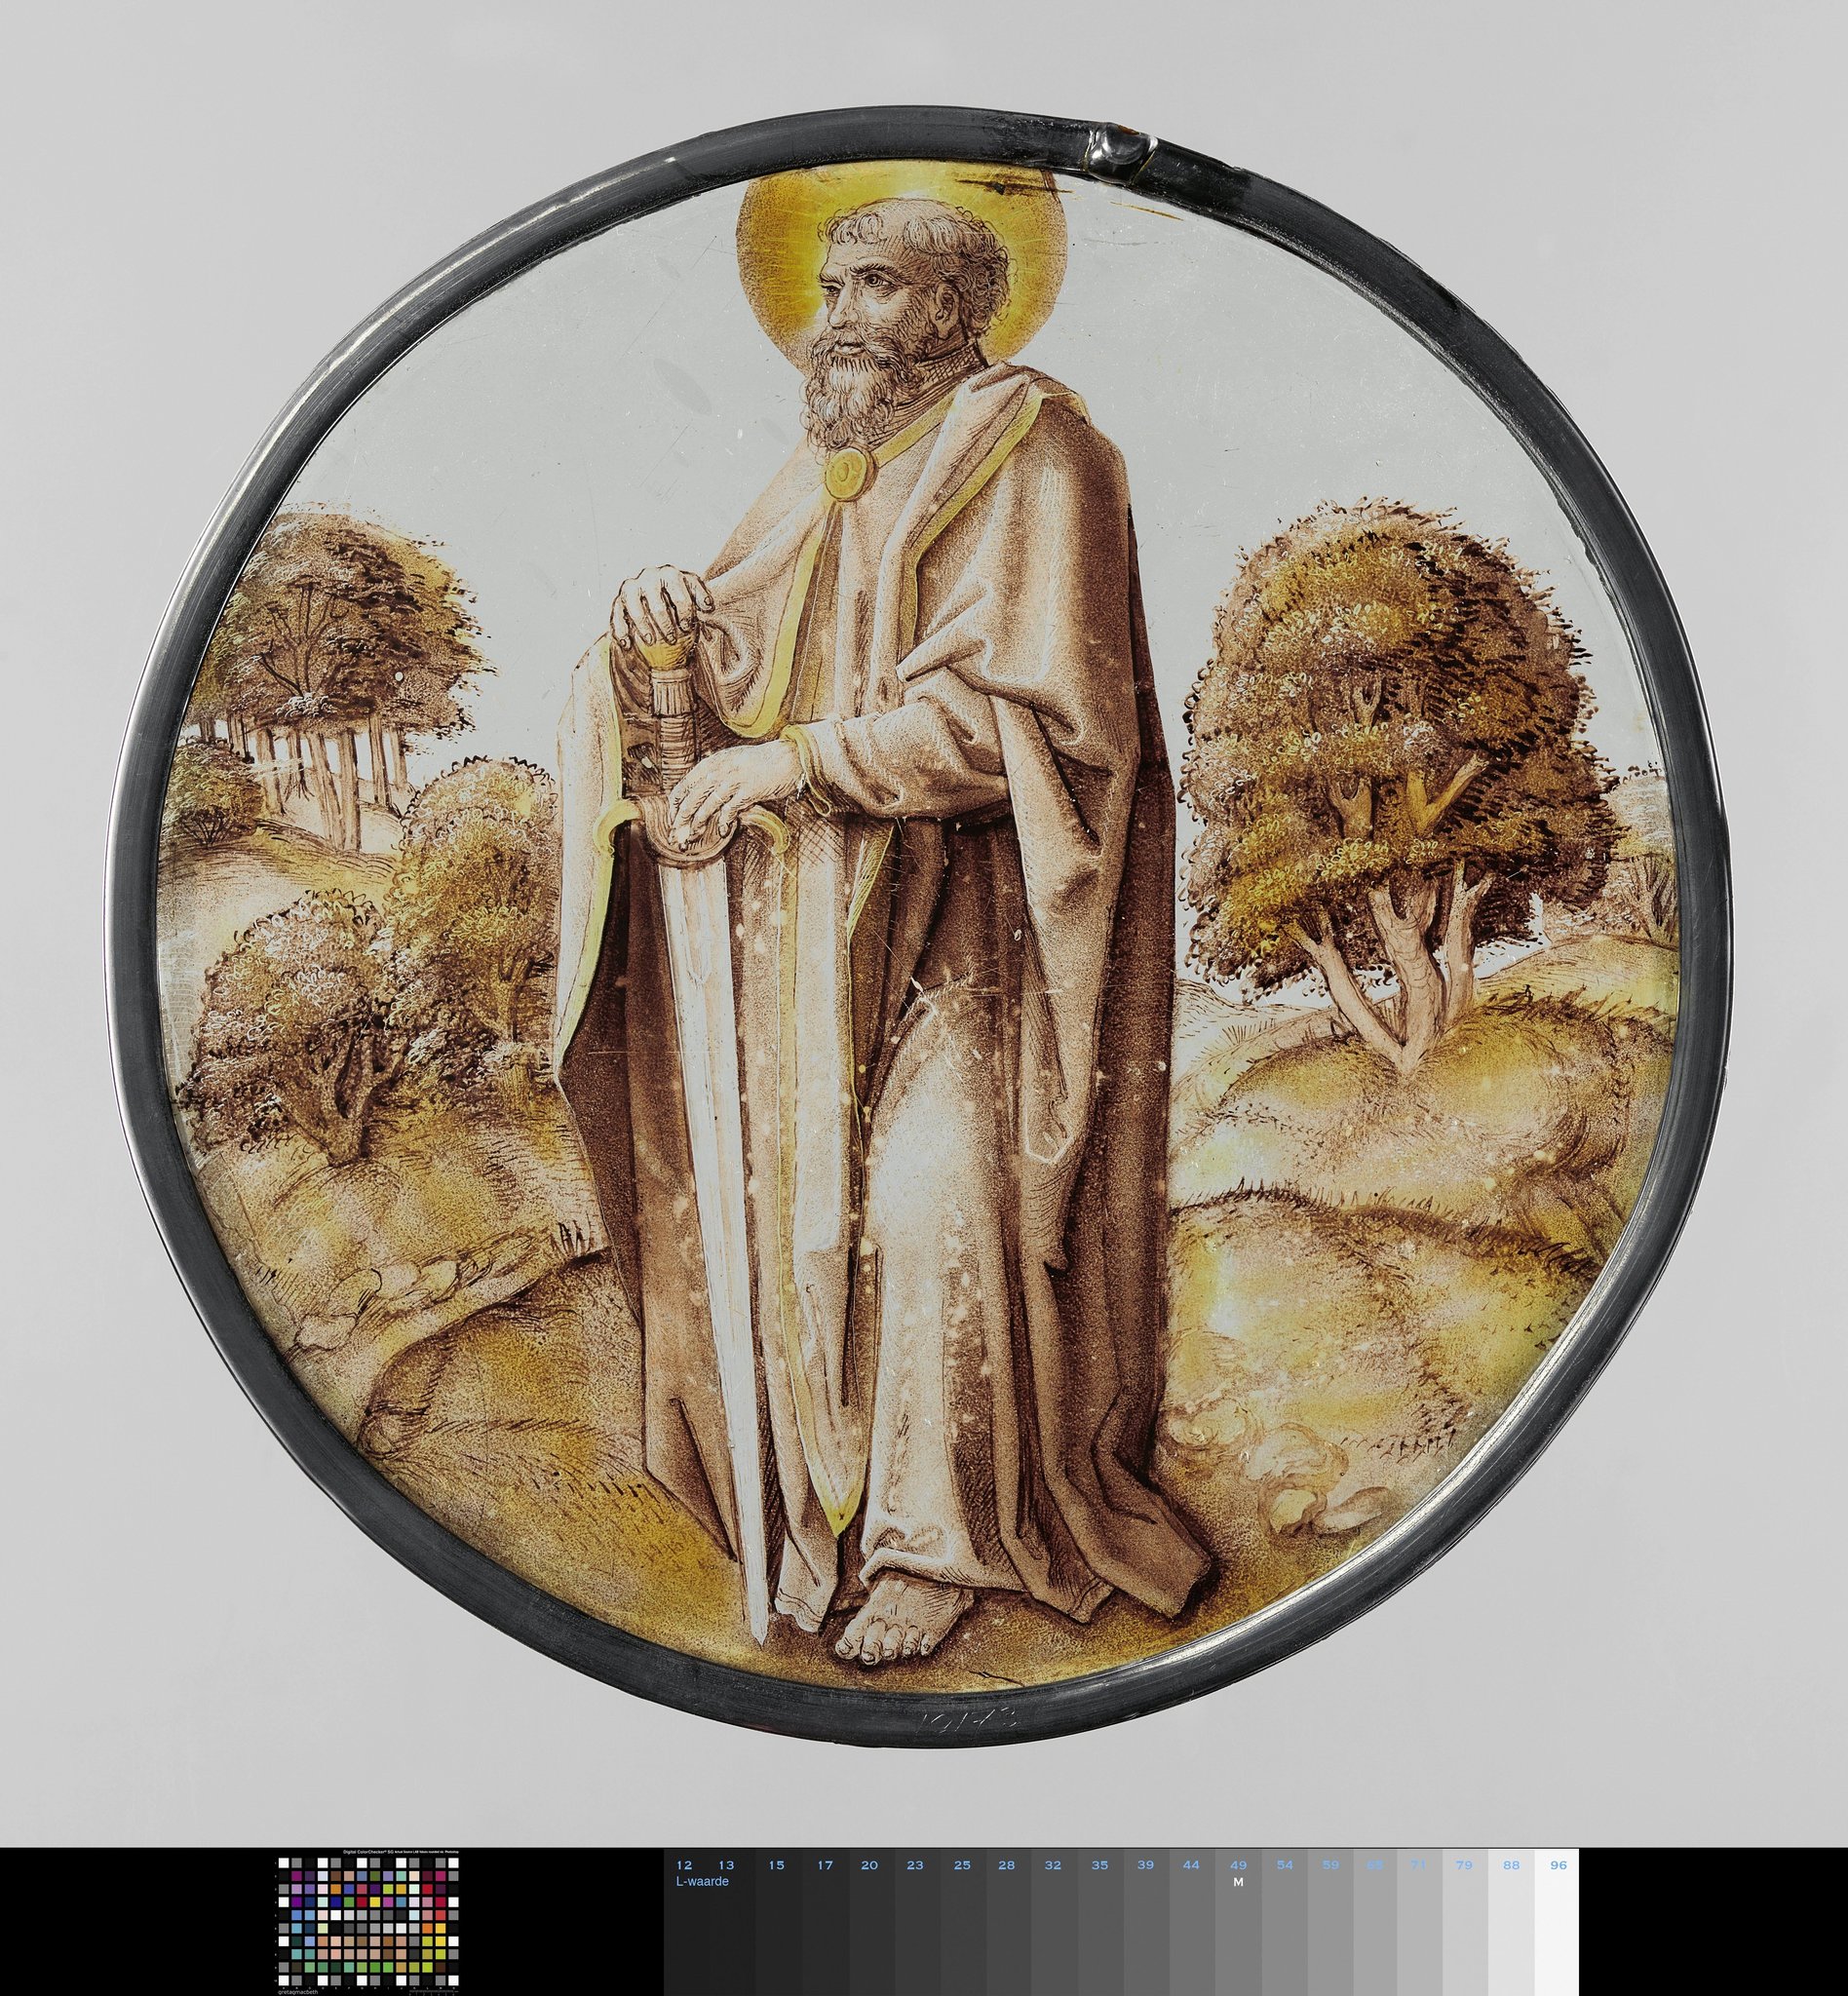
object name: light window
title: Ruit met de apostel Paulus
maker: Anonymous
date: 1525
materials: glass, lead, pigment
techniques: leading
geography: lower rhine region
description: St Paul. Stained glass. Germany (?), c. 1525.